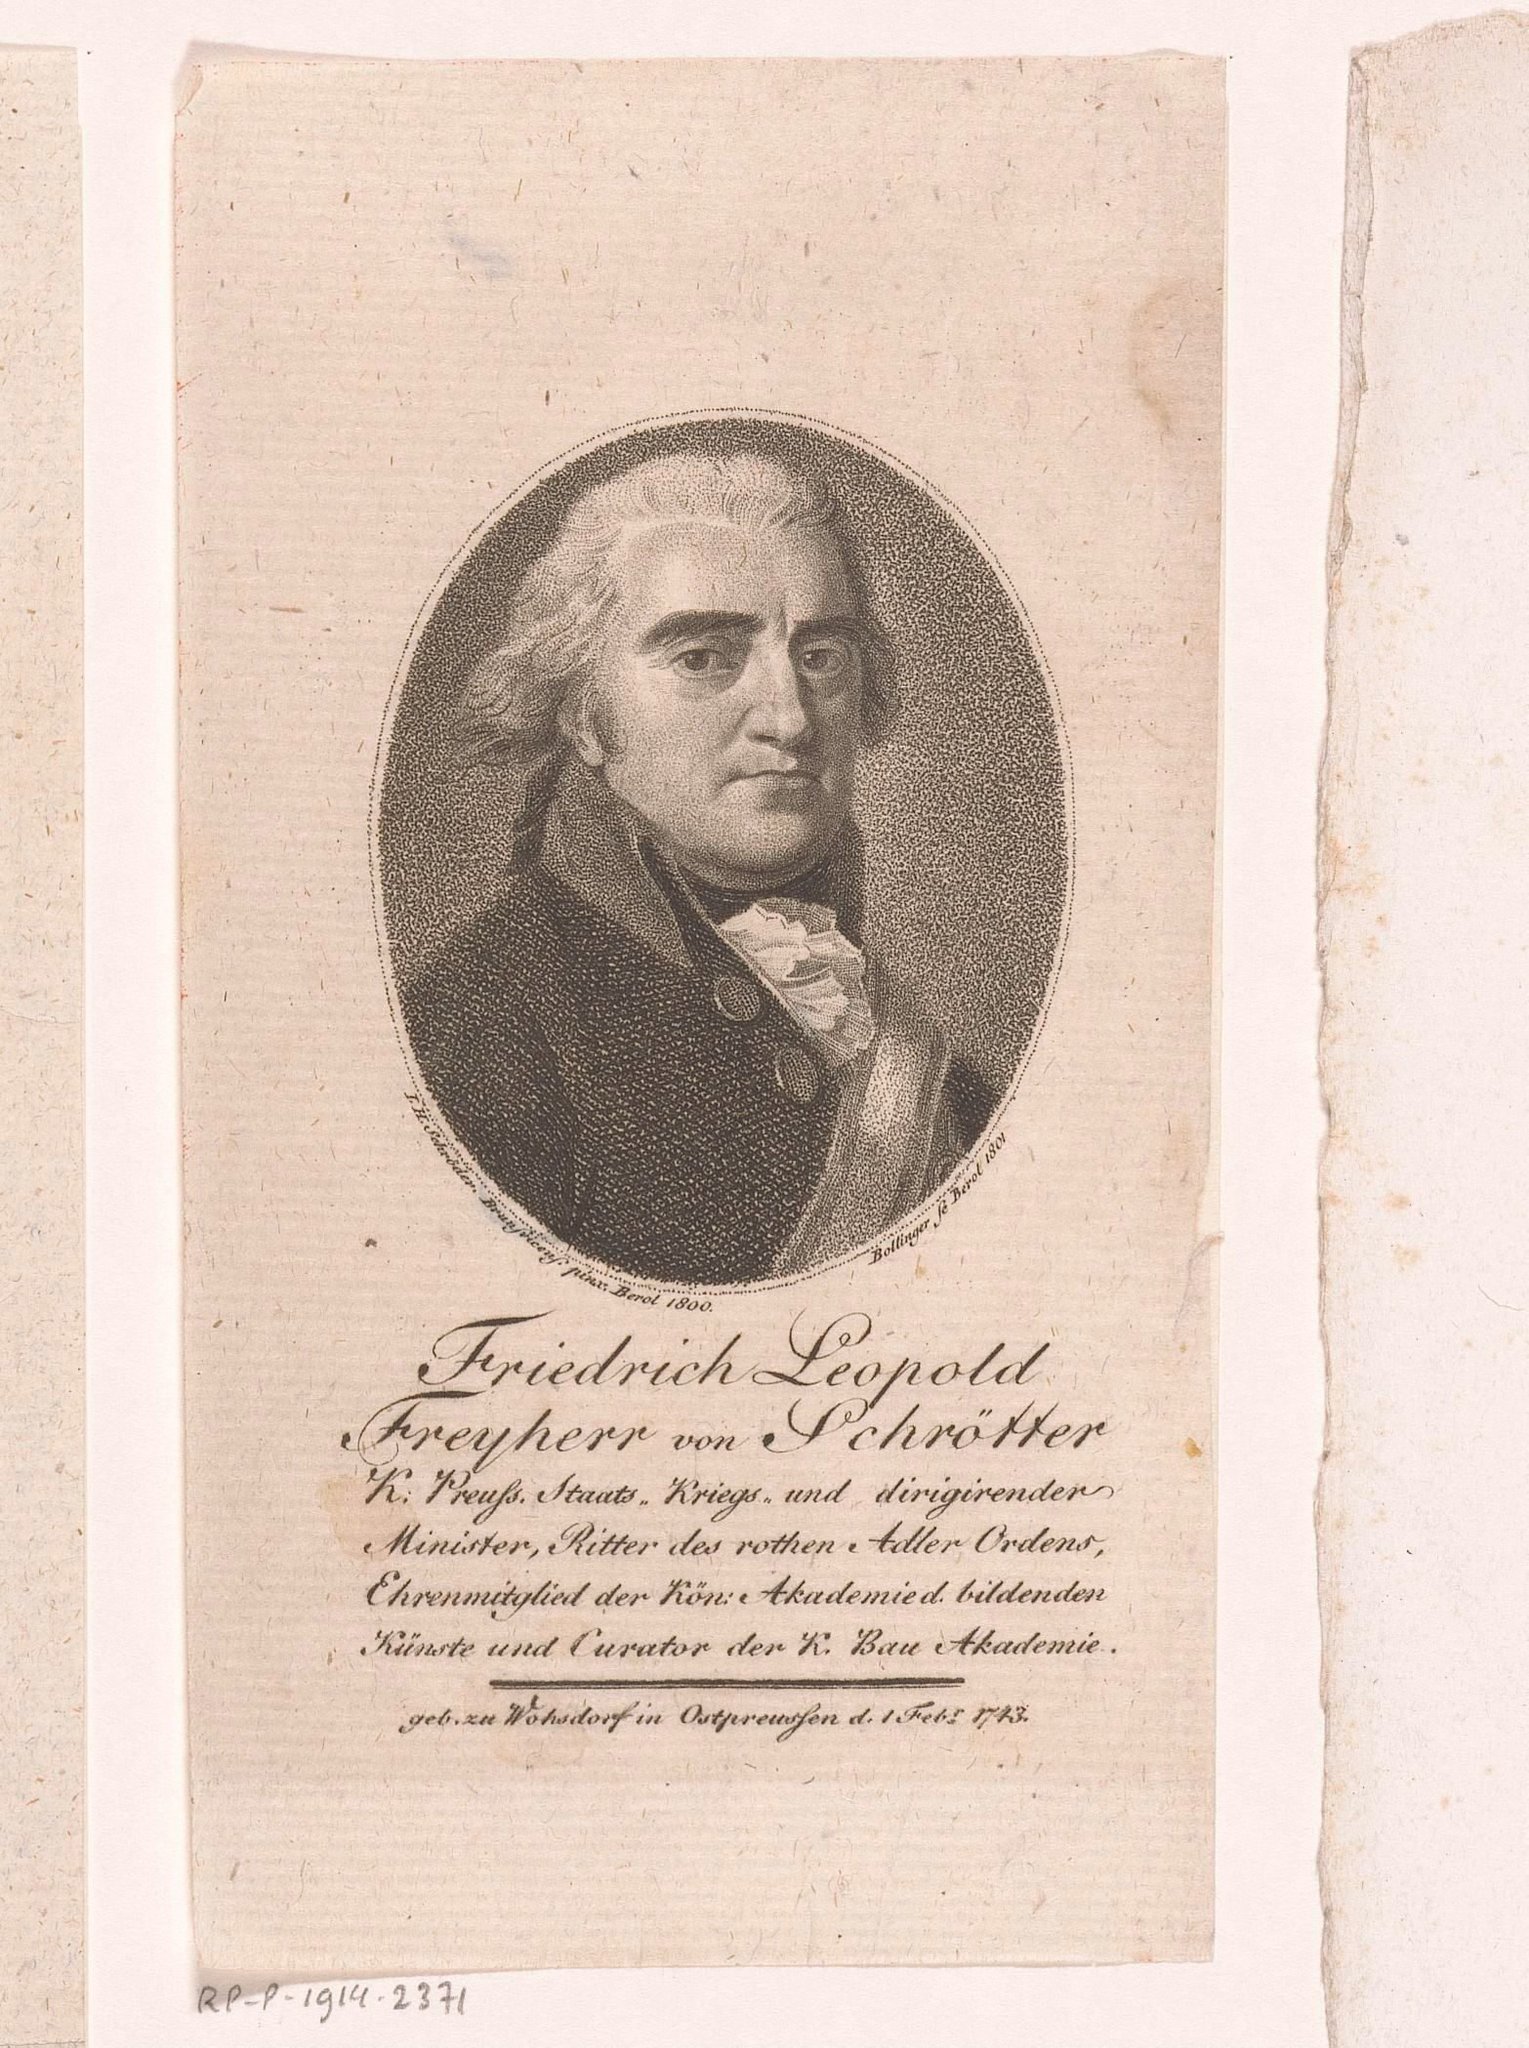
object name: print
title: Portret van Friedrich Leopold, Freiherr von Schrötter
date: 1800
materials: paper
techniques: stippling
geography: berlin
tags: berlin, historical persons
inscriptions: collector's mark: Lugt 2228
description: Prent ook gebruikt in: Neue Berlinische Monatschrift, juli 1801.